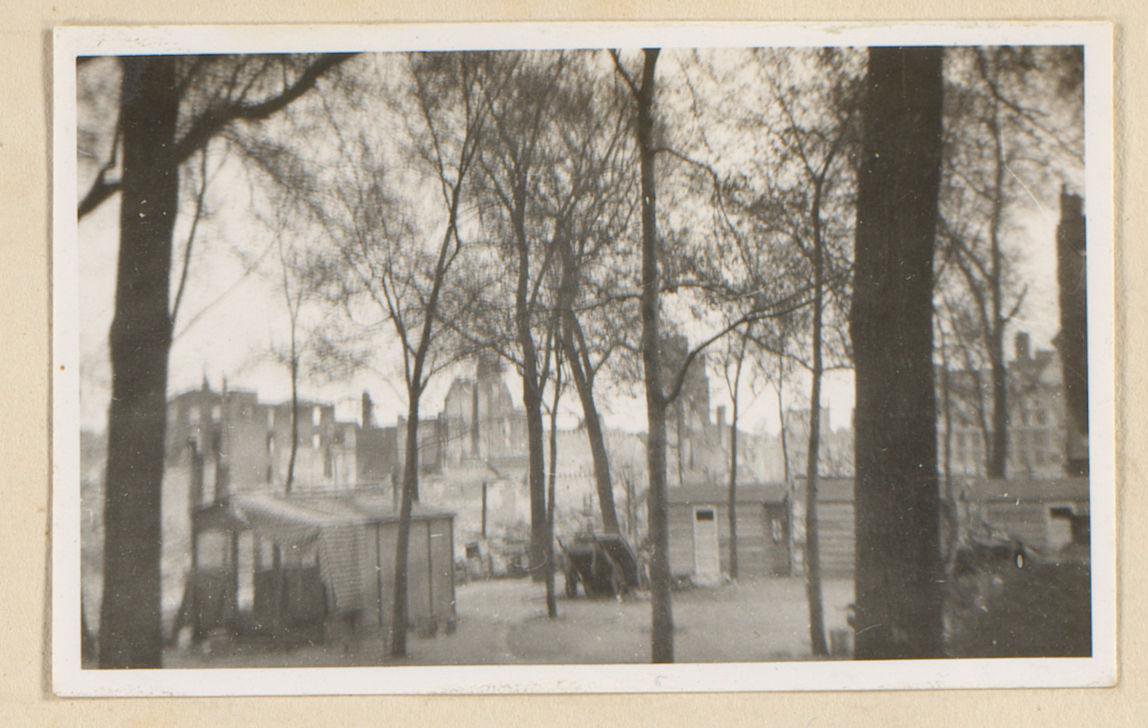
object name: photograph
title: Ruïnes van de Nieuwe Markt te Rotterdam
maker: j. nolte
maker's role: fotograaf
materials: photographic support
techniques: gelatin silver print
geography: rotterdam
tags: trees, devastated, ruined place or city (~ warfare), ruin of a dwelling, house, castle, etc., rotterdam, rotterdam blitz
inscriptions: annotation: ‘Gezicht van de Nieuwe Markt naar 't Westen.’